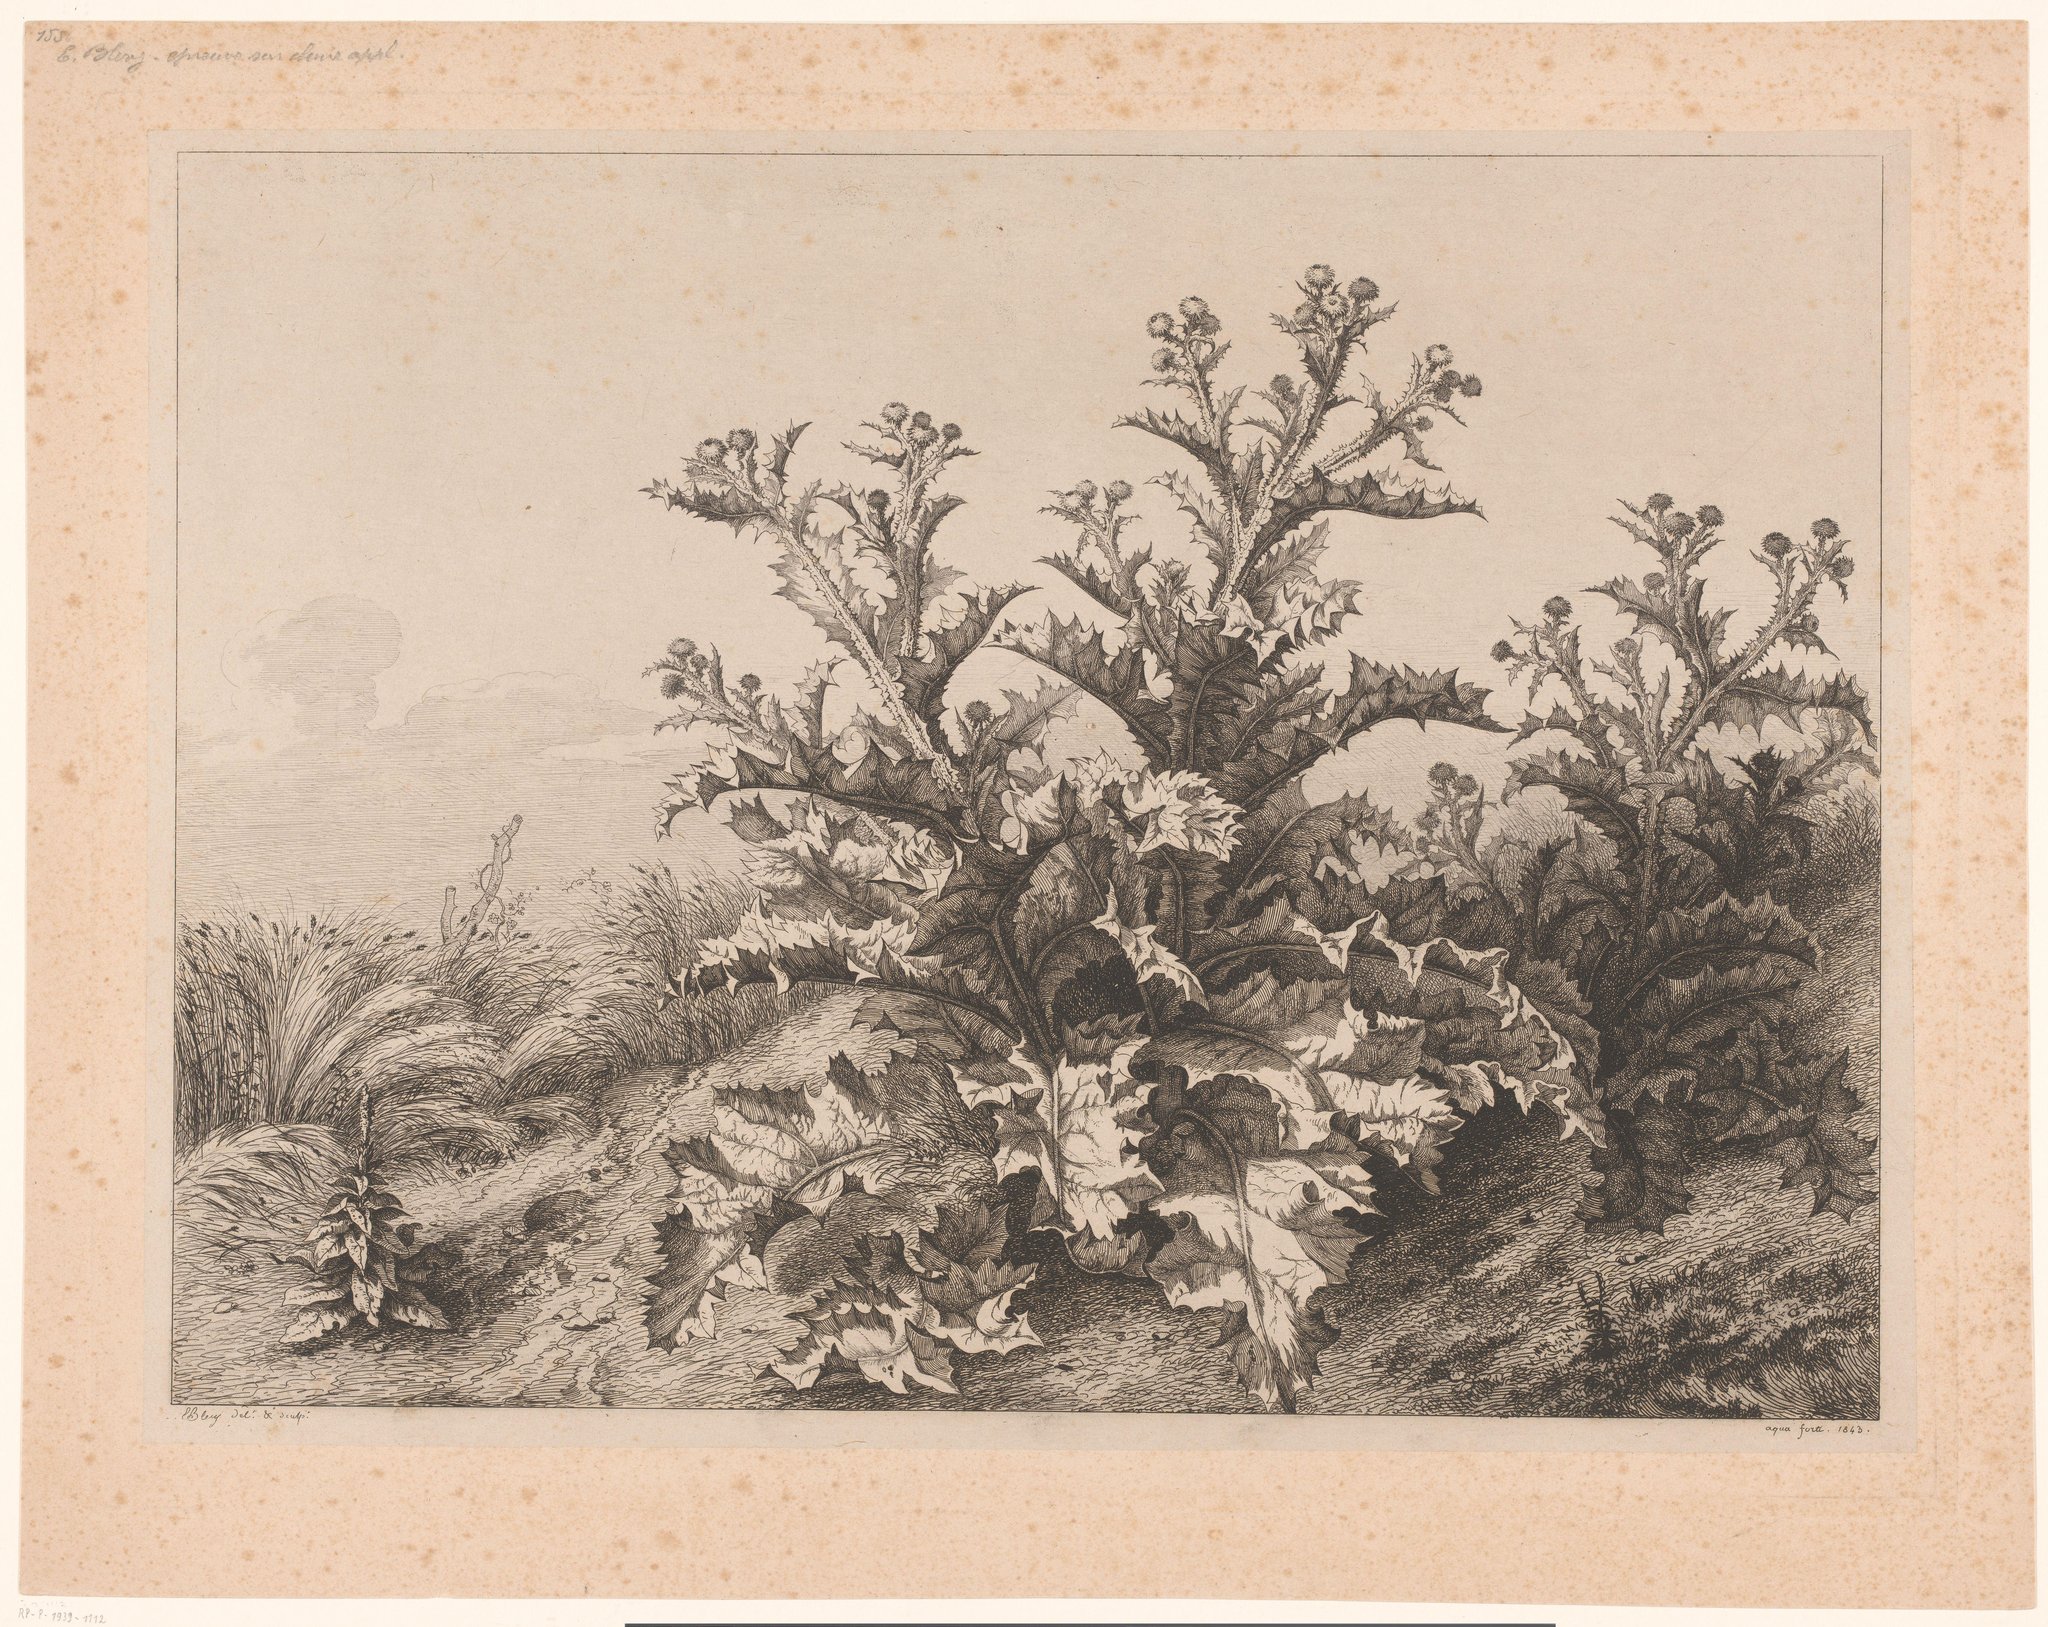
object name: print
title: Vier grote plantsoorten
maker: eugène bléry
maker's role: print maker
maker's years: 1805-1887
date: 1843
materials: paper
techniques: drypoint, engraving, etching, roulette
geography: france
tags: plants and herbs: thistle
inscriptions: collector's mark: Lugt 2166, collector's mark: Lugt 2760